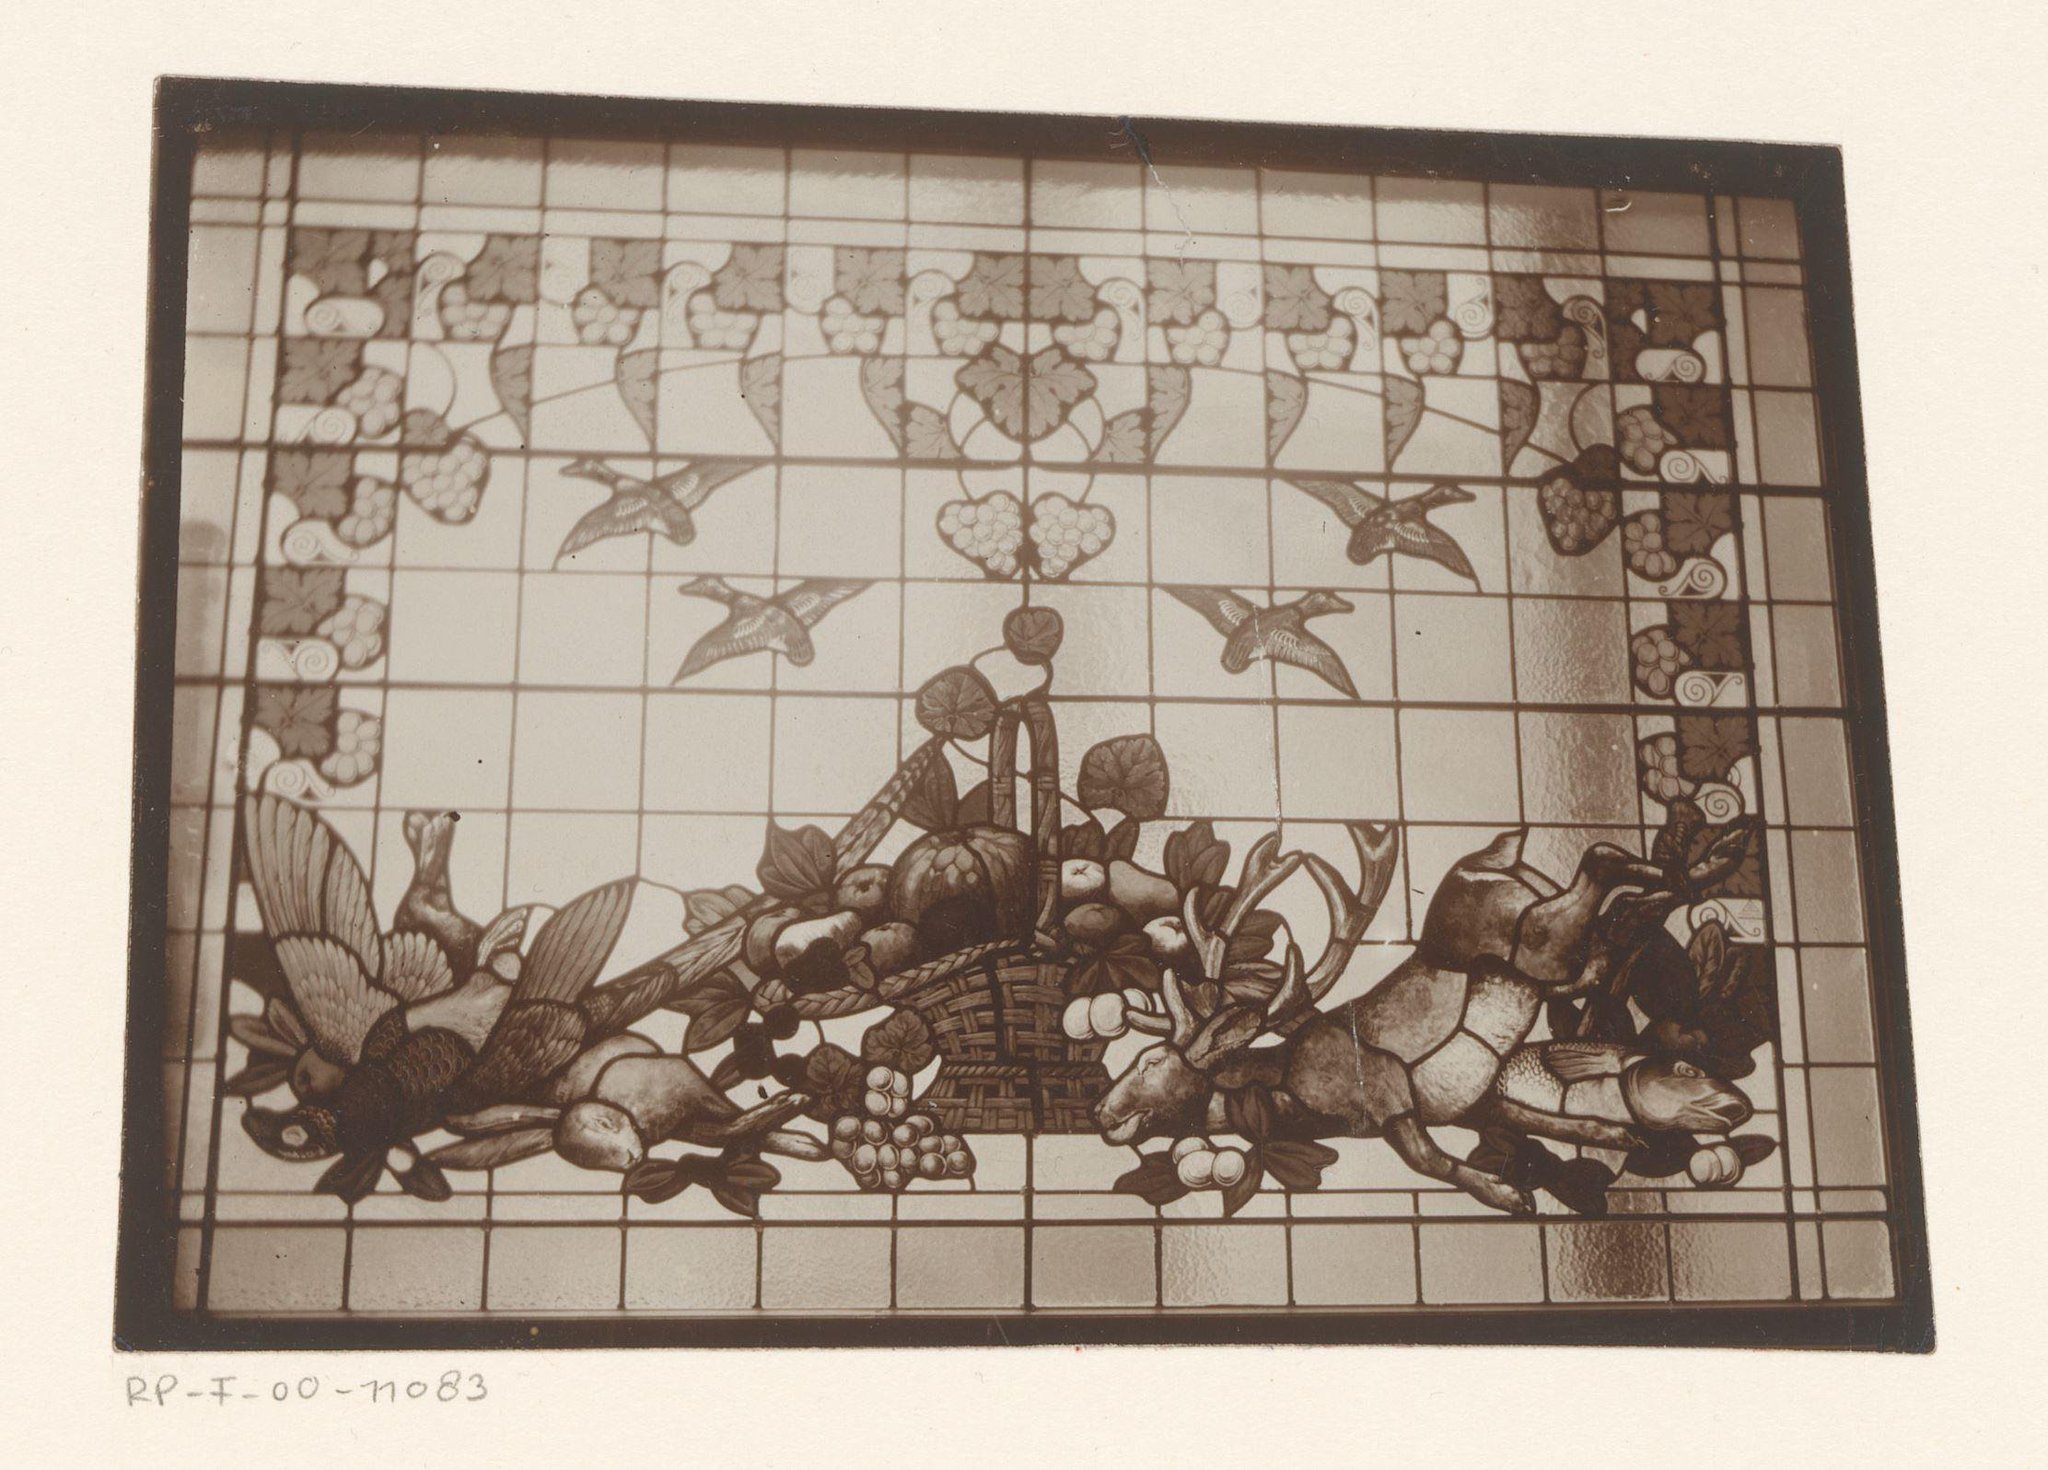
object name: photograph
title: Glas in loodraam met een fruitmand, wild, gevogelte en vis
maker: Anonymous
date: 1907-1930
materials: photographic support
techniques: collodion silver print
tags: hoofed animals: deer, fishes, fowl (cock, hen, chicken, etc.), work of monumental art, fruits